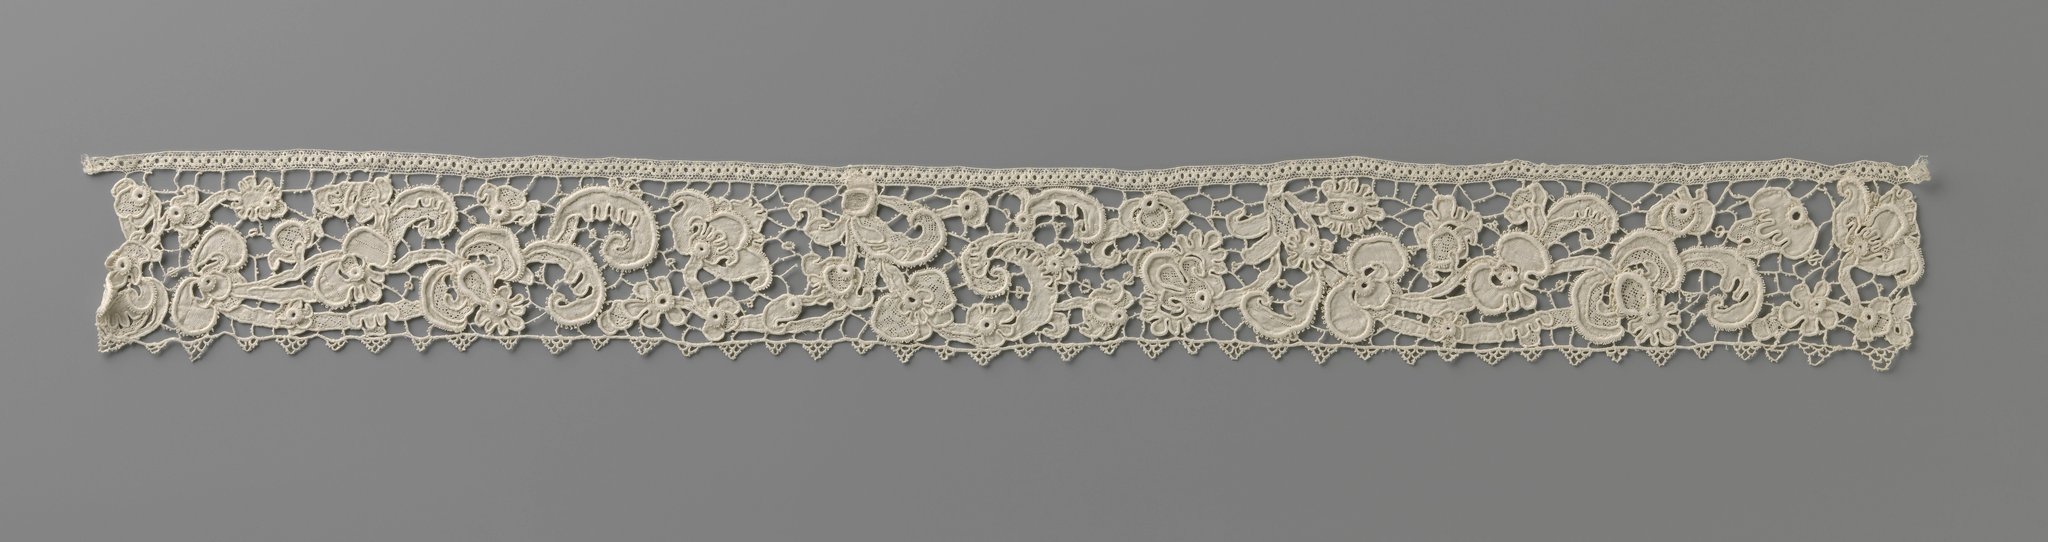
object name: strip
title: Strook naaldkant met dubbele ranken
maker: Anonymous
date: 1875-1909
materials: linen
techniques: embroidery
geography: burano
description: Strook naturelkleurige naaldkant: Venetiaanse reliëfkant. Los verspreide, kleine en middelgrote palmetbloemen groeien aan dikke, verdubbelde stengels, die aan de rechte binnenkant abrupt ontspringen. Een open spijlengrond vormt de ondergrond. Randje met driehoekjes.